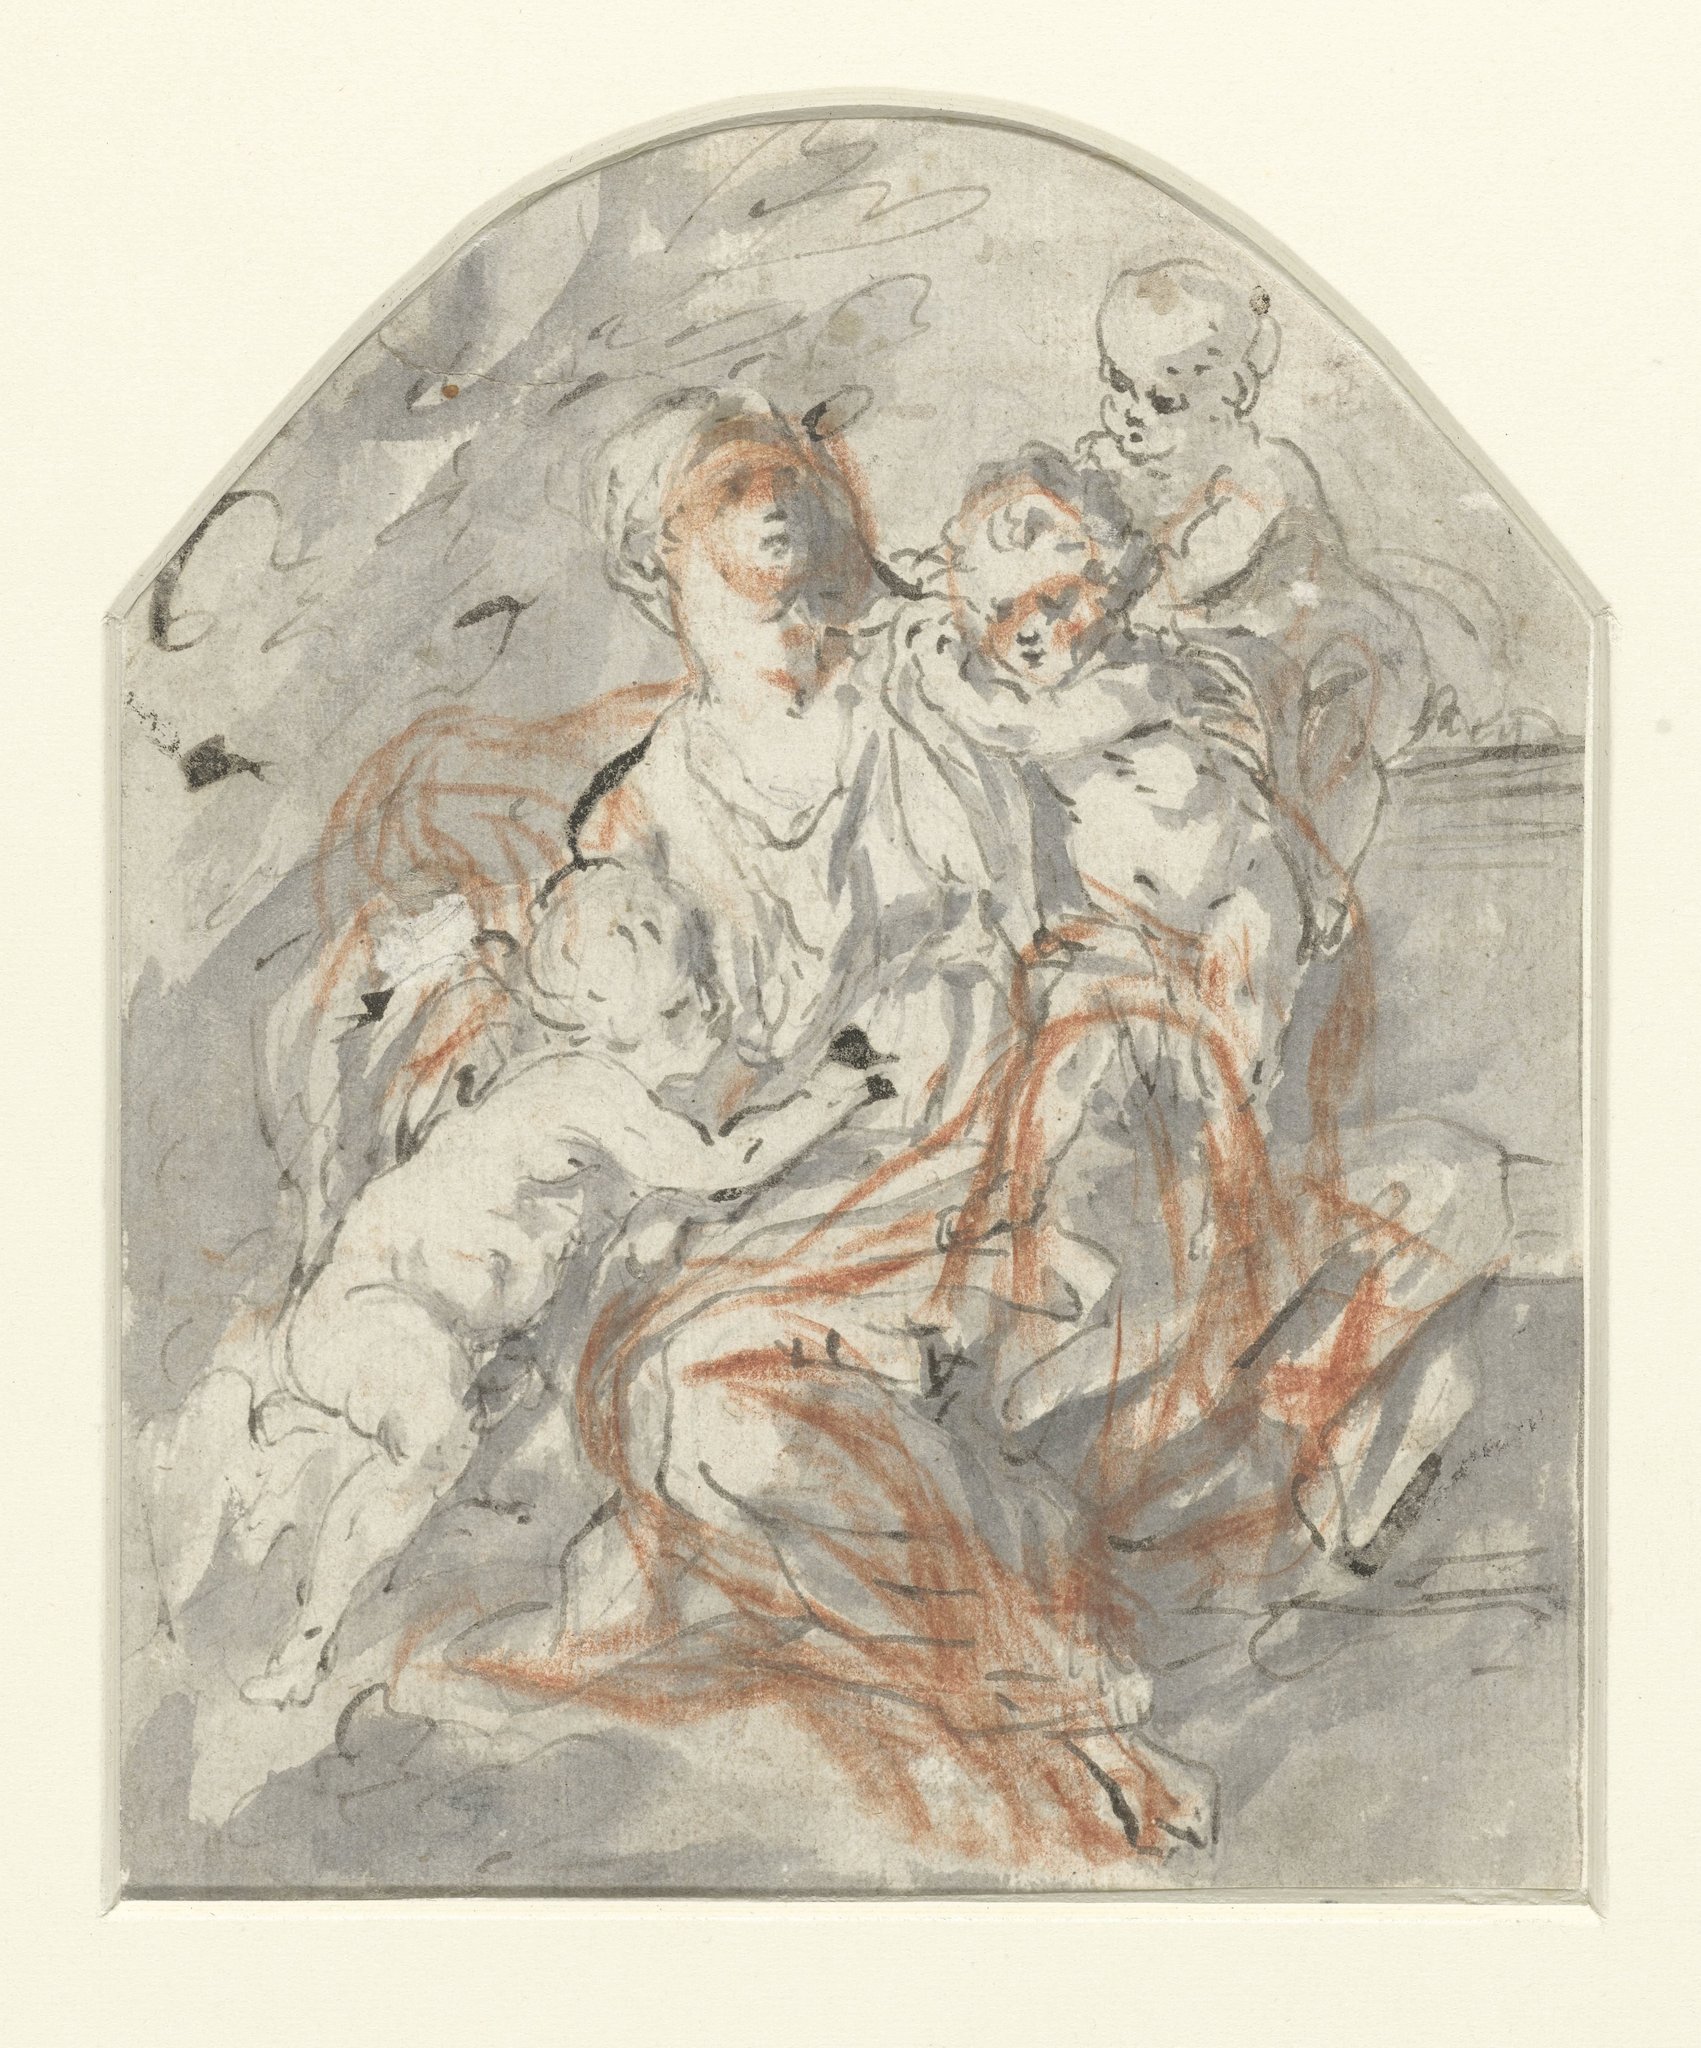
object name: drawing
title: Vrouw (Caritas?) met drie kinderen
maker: Anonymous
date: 1700-1800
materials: chalk, ink, paper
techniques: brush, pen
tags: charity, 'caritas'; 'carità' (ripa) ~ one of the three theological virtues, mother-love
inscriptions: collector's mark, verso, lower centre: Lugt 2228